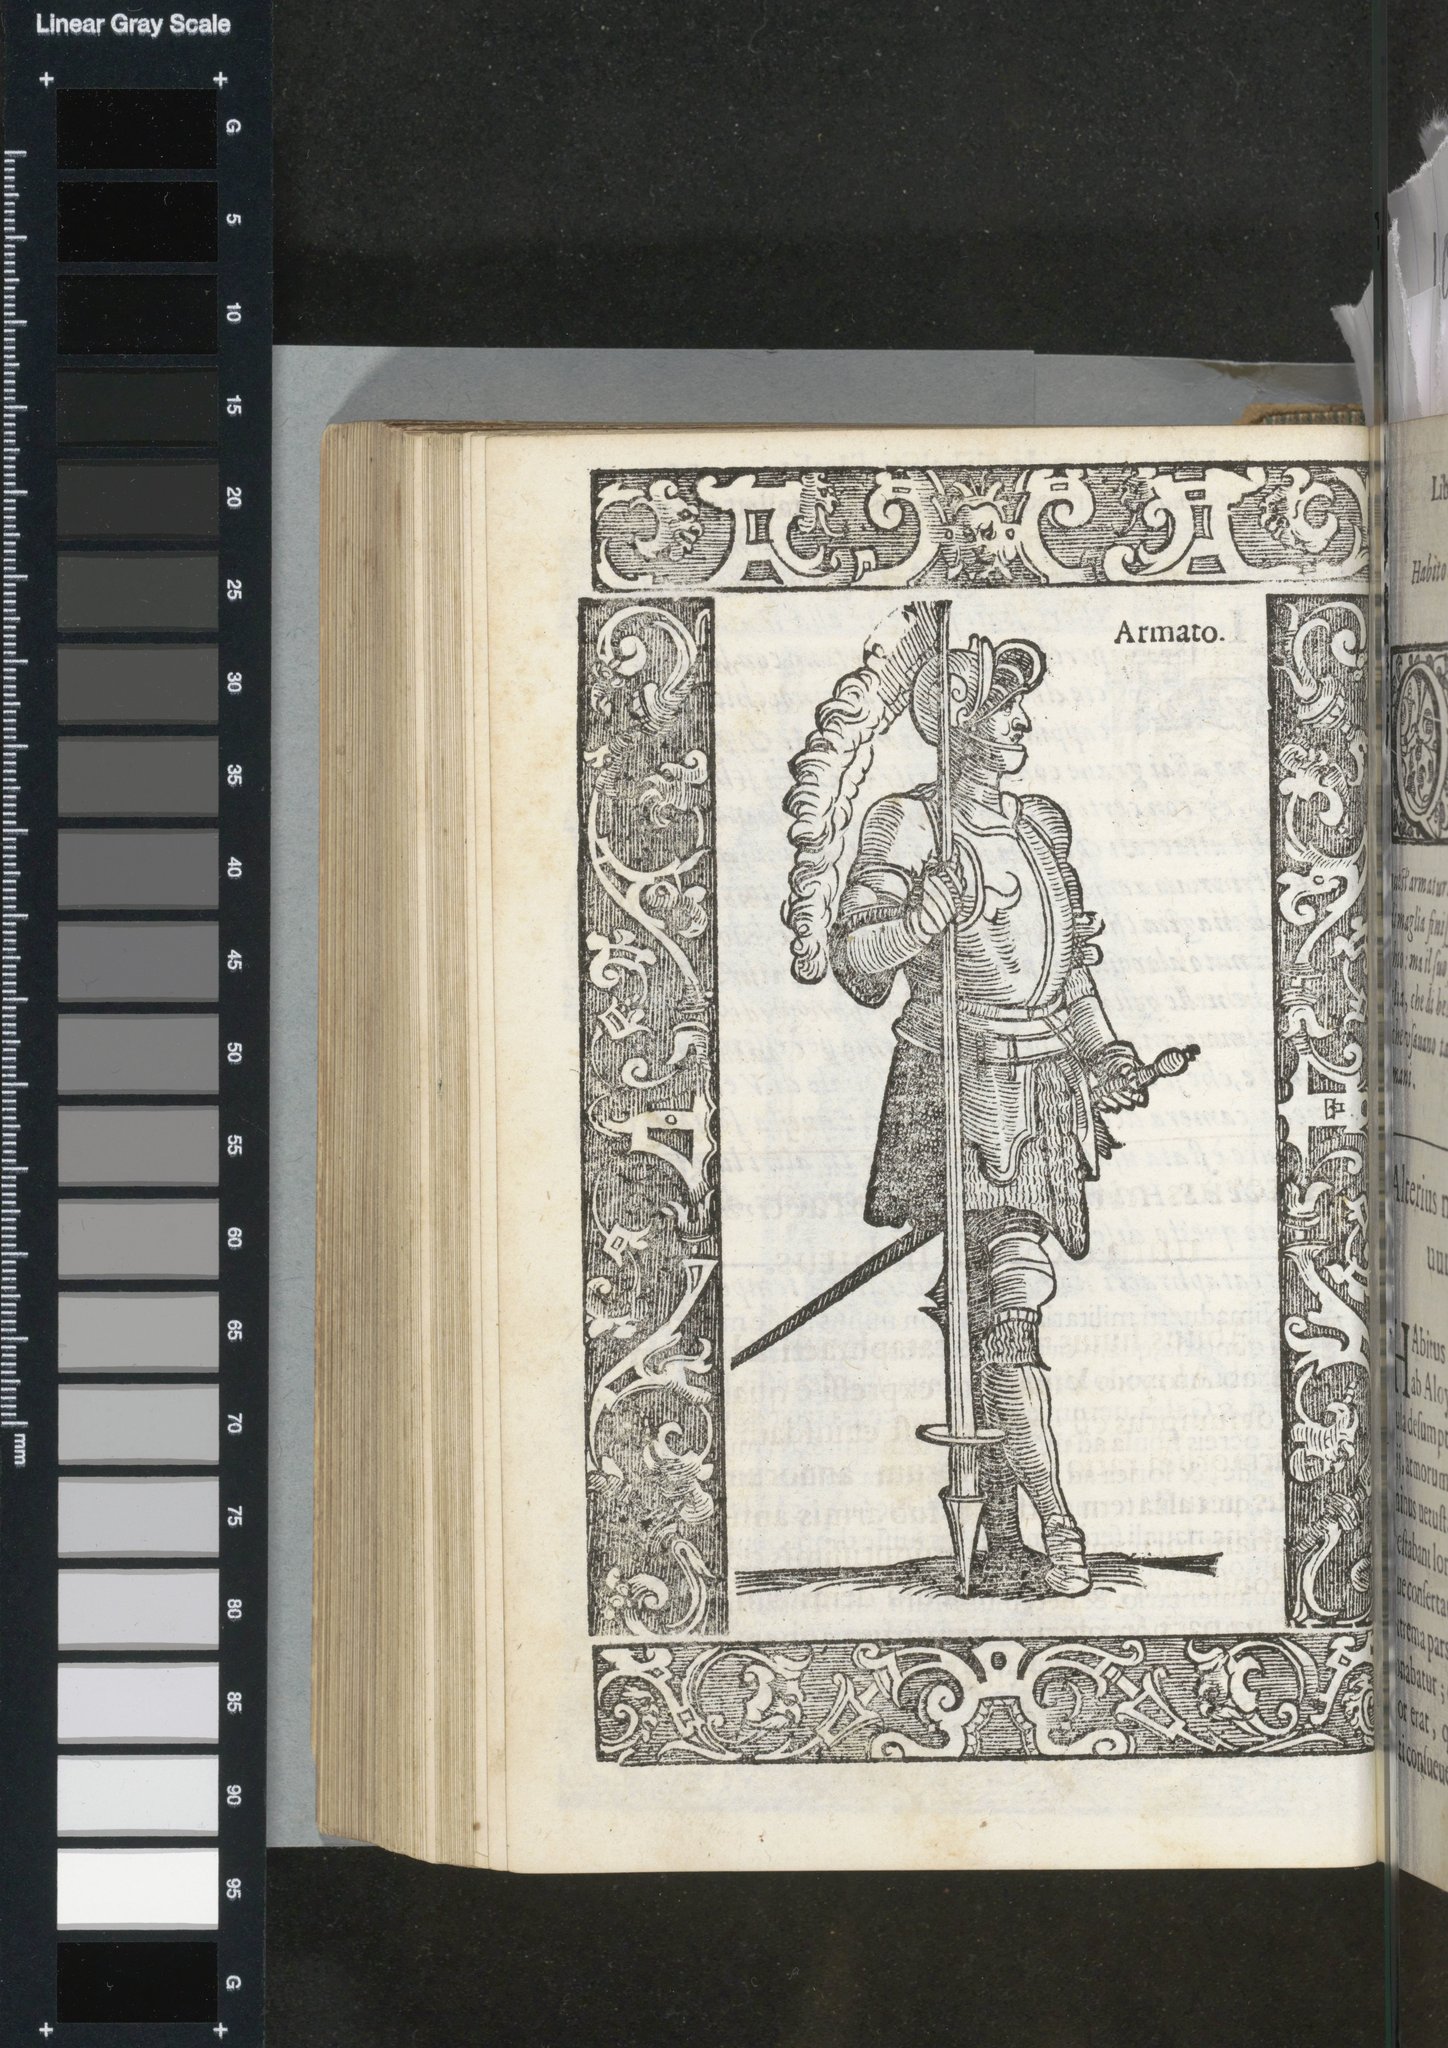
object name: costume print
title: Armato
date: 1598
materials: paper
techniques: woodcut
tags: fashion plates